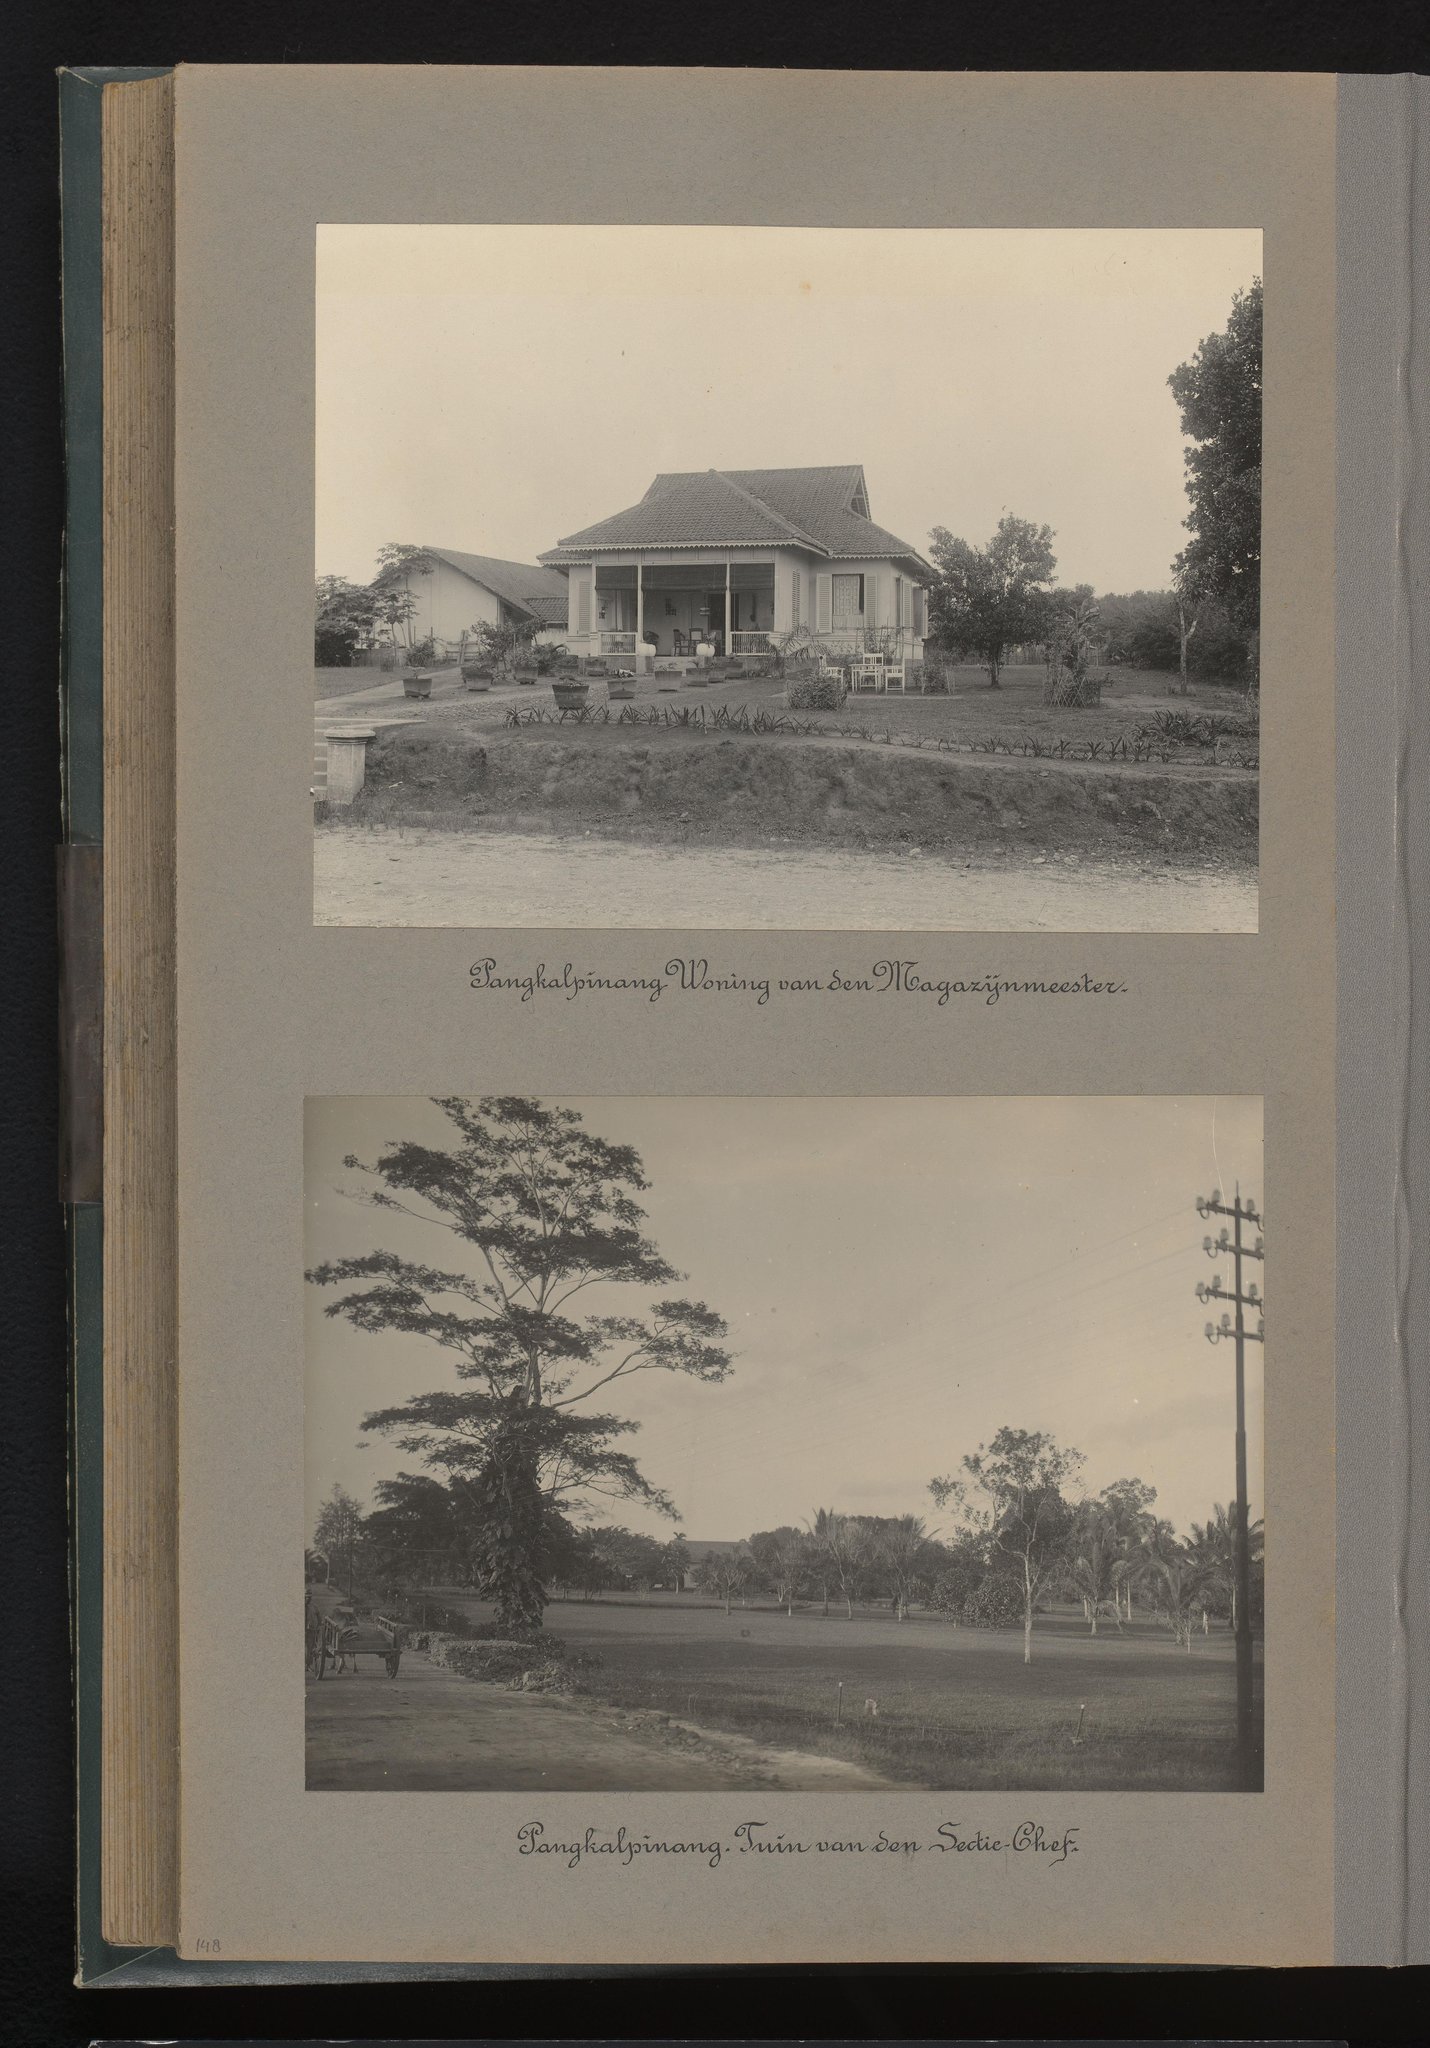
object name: photograph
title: Woning en tuin te Pangkalpinang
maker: Anonymous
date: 1914-1919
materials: cardboard, photographic support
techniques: gelatin silver print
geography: bangka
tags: robert julius boers, colonial system, mining, villa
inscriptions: inscription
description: Albumblad met 2 foto's van een woning en tuin van de mijnbouwonderneming te Pangkalpinang. Onderdeel van het fotoalbum aangeboden aan Robert Julius Boers bij zijn vertrek naar Nederland in 1919 door het personeel van de Banka-tinwinning.